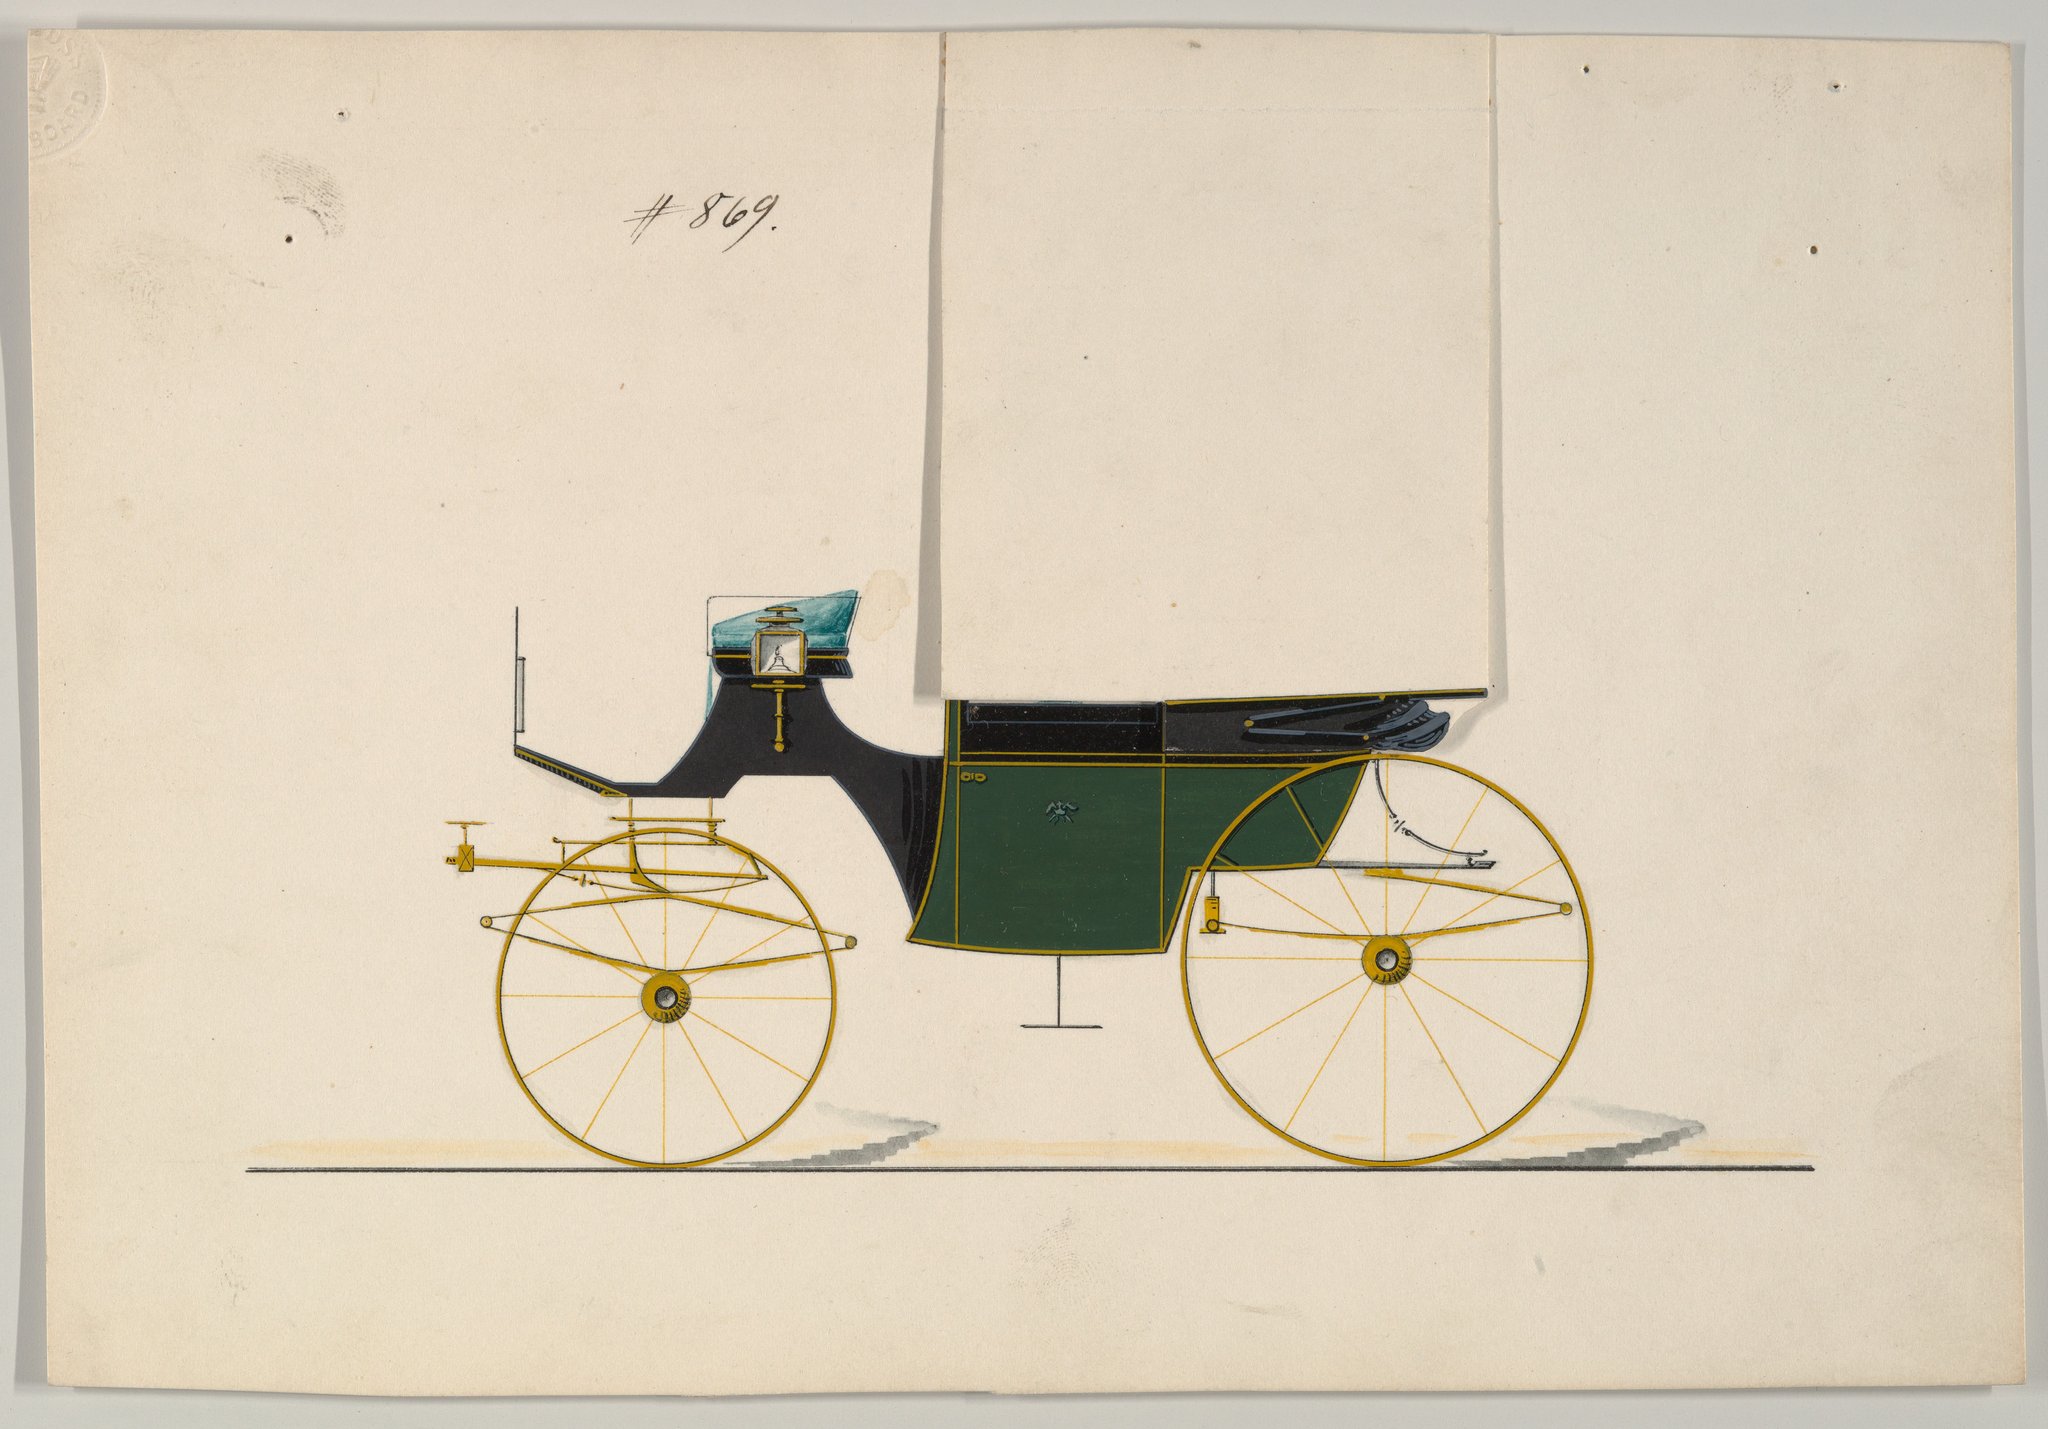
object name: drawing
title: Landaulet #869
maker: brewster & co.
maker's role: manufacturer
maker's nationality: american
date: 1850-1870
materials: gouache, gum arabic, ink, watercolor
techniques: pen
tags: carriages